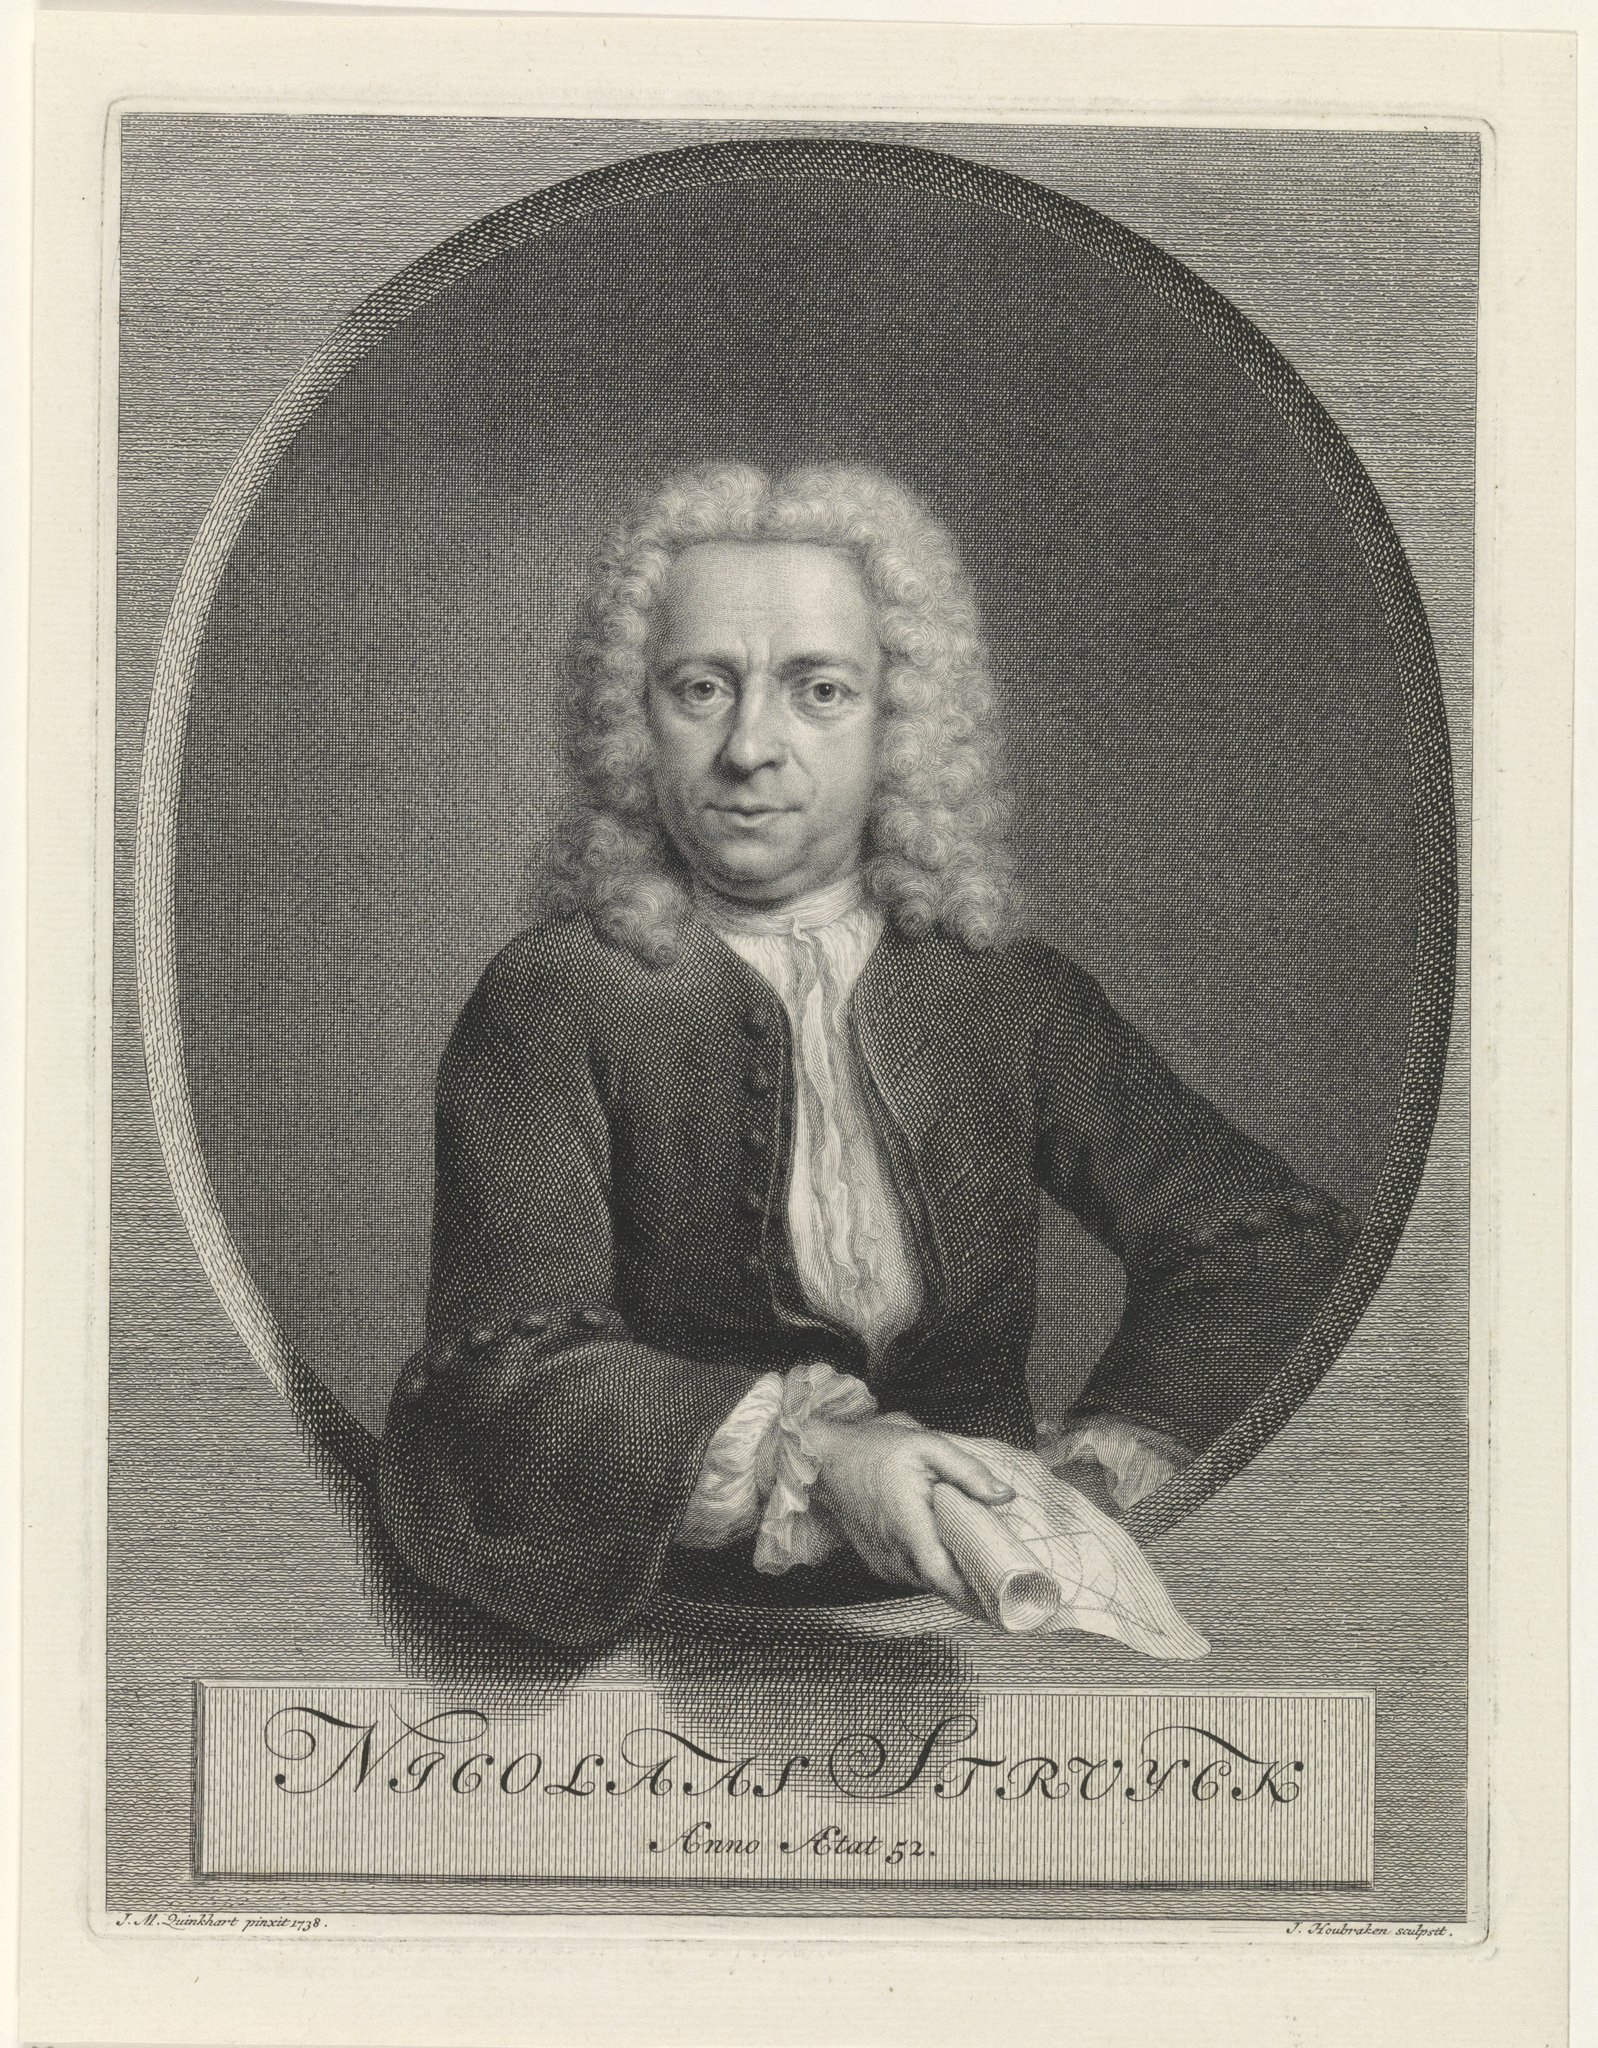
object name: print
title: Portret van Nicolaas Struyck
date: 1738-1780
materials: paper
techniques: engraving, etching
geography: amsterdam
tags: mathematicus, nicolaas struyck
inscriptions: collector's mark: Lugt 240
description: Portret ten halven lijve van Nicolaas Struyck op 52-jarige leeftijd in een architectonisch ovaal, waarbij zijn linkerhand met daarin een opgerolde tekening over de rand steekt. Onder het ovaal een cartouche met zijn naam en zijn leeftijd in twee regels.